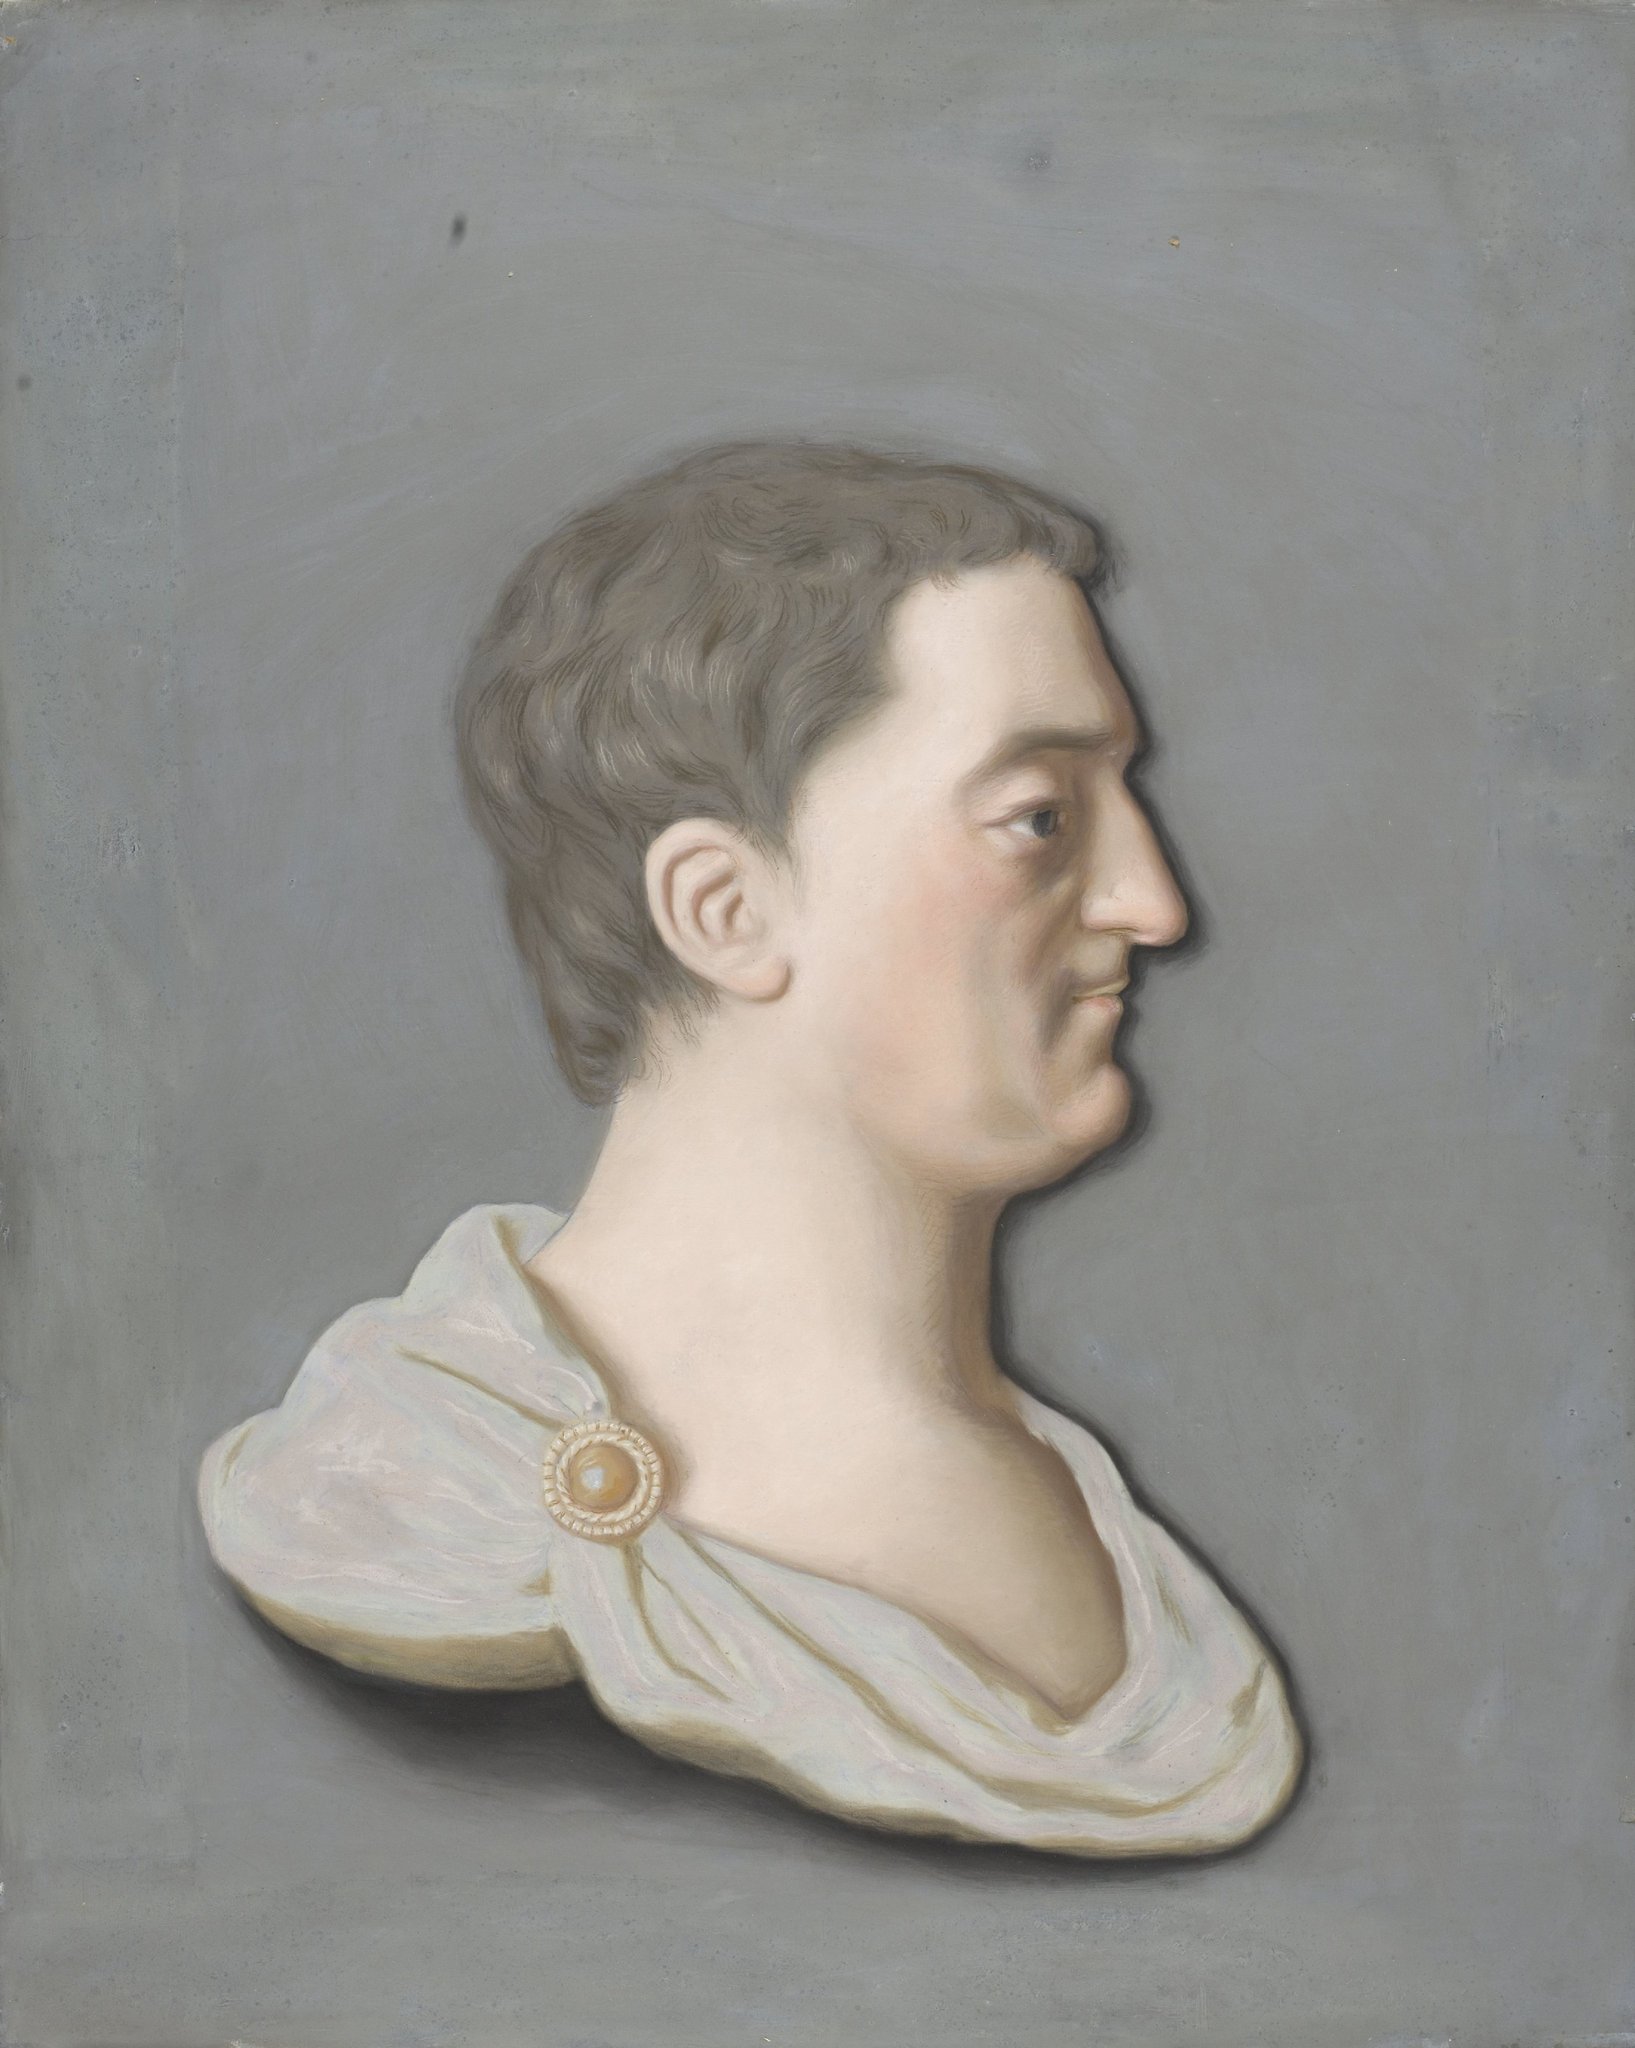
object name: pastel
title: Sir William Ponsonby (1704-93). Later earl van Bessborough, Friend and Travel Companion of Liotard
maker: jean-etienne liotard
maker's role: painter, print maker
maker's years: 1702-1789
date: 1750-1760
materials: parchment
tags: william ponsonby (2e graaf van bessborough), historical persons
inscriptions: inscription: ‘Milord Besborough ami de & peint par Liotard’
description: Ponsonby first encountered Liotard at Rome in 1738 and took him as his draughtsman to Constantinople, where the artist’s independent career began. He remained a loyal friend and patron, eventually owning some 70 works by Liotard. This portrait was presumably made during one of Liotard’s two sojourns in London. It is one of Liotard’s rare excursions into Neoclassicism, and presents the sitter as a trompe l’oeil Roman shell cameo.